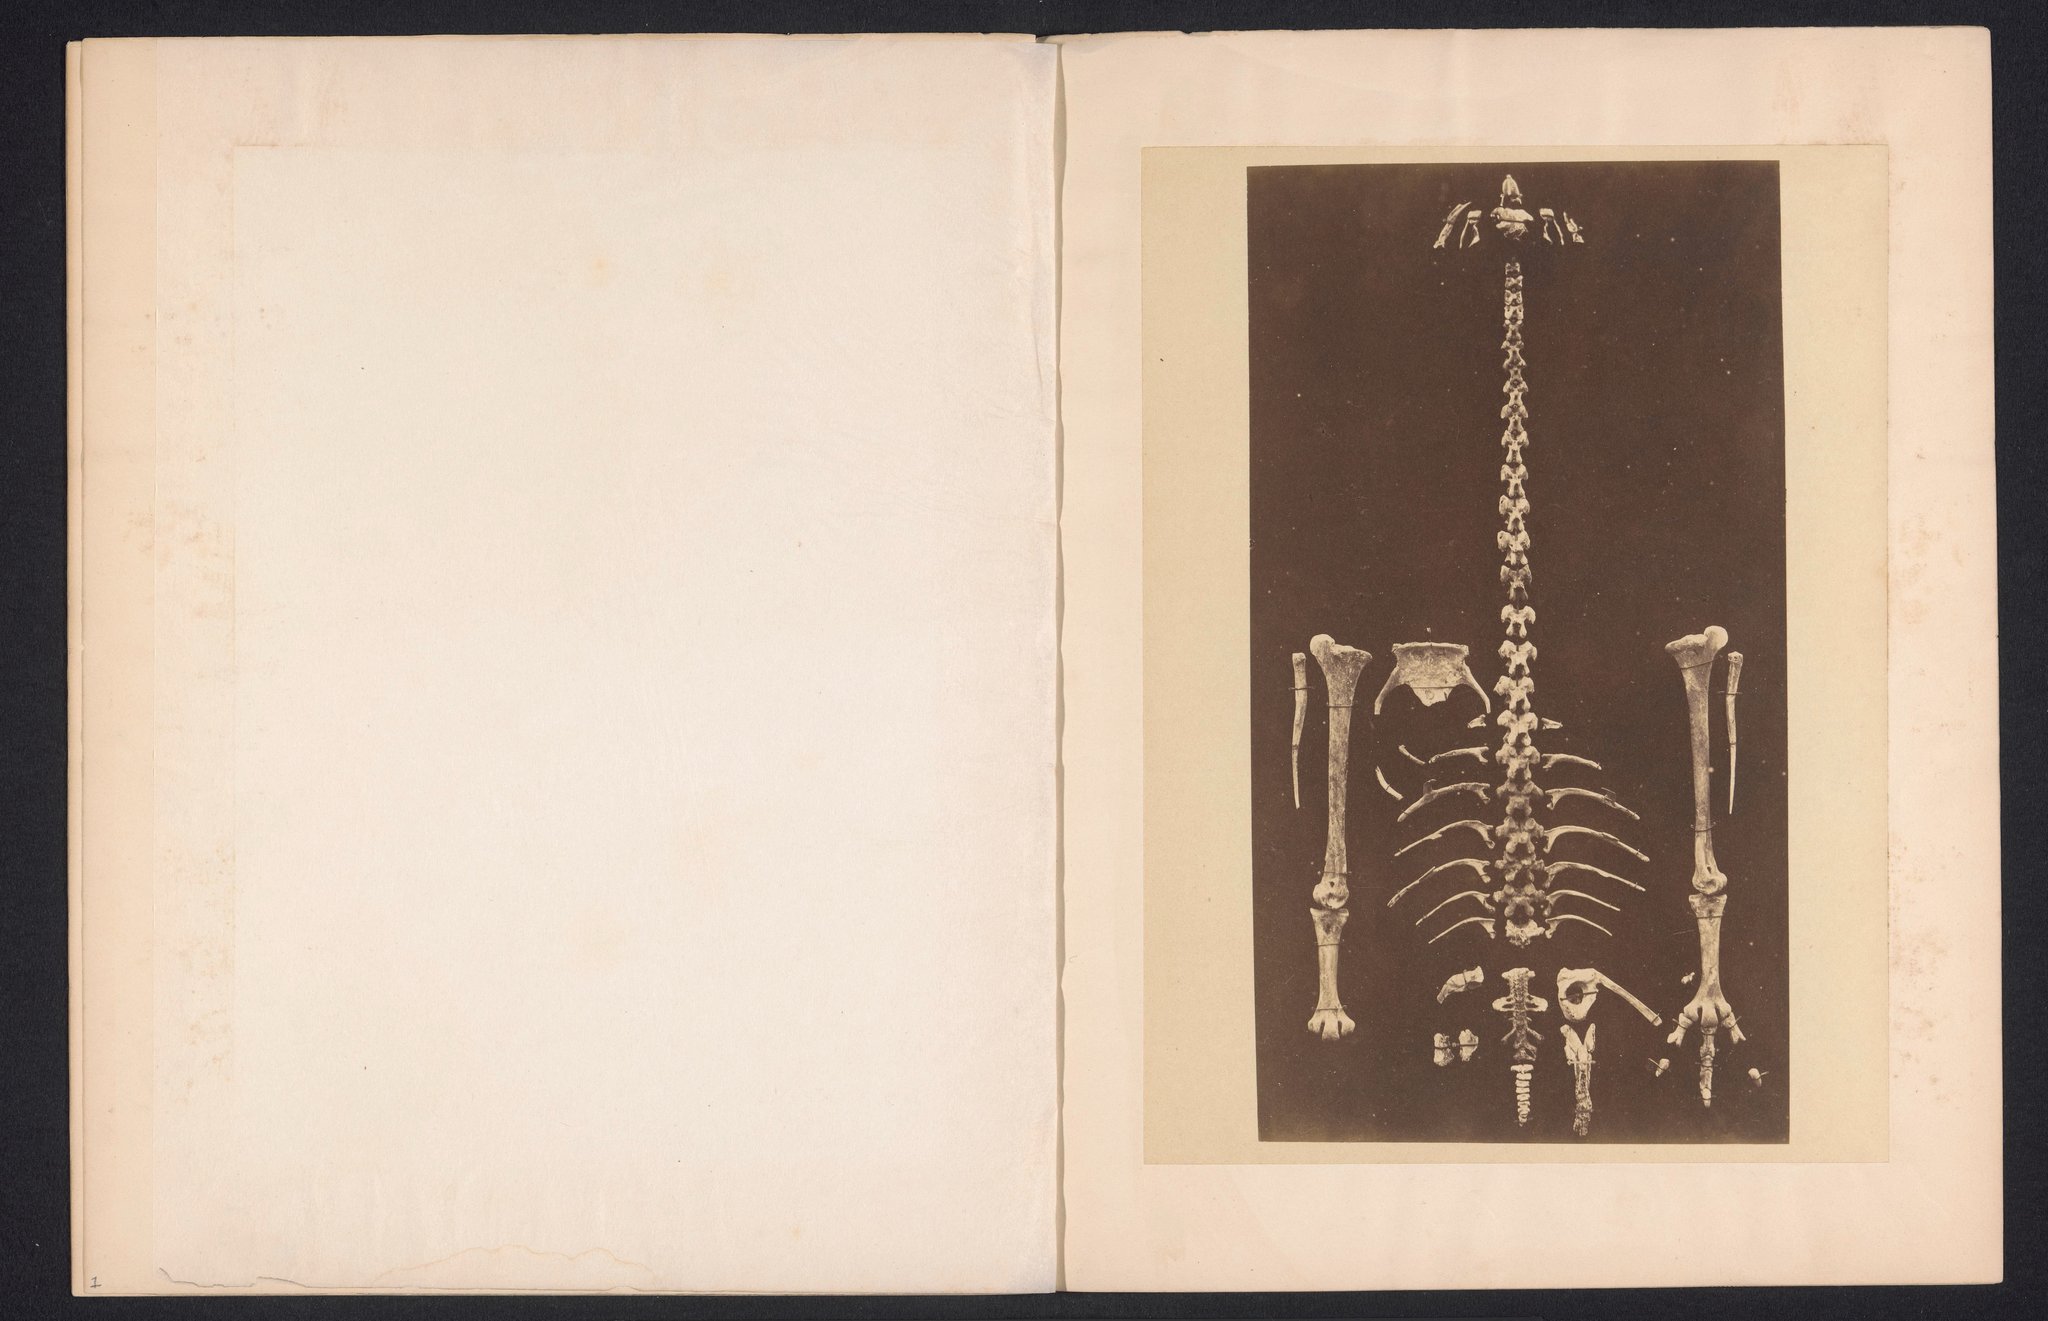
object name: page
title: Botten van vermoedelijk een moa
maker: Anonymous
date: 1853-1863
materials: photographic support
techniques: albumen print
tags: walker and runner birds